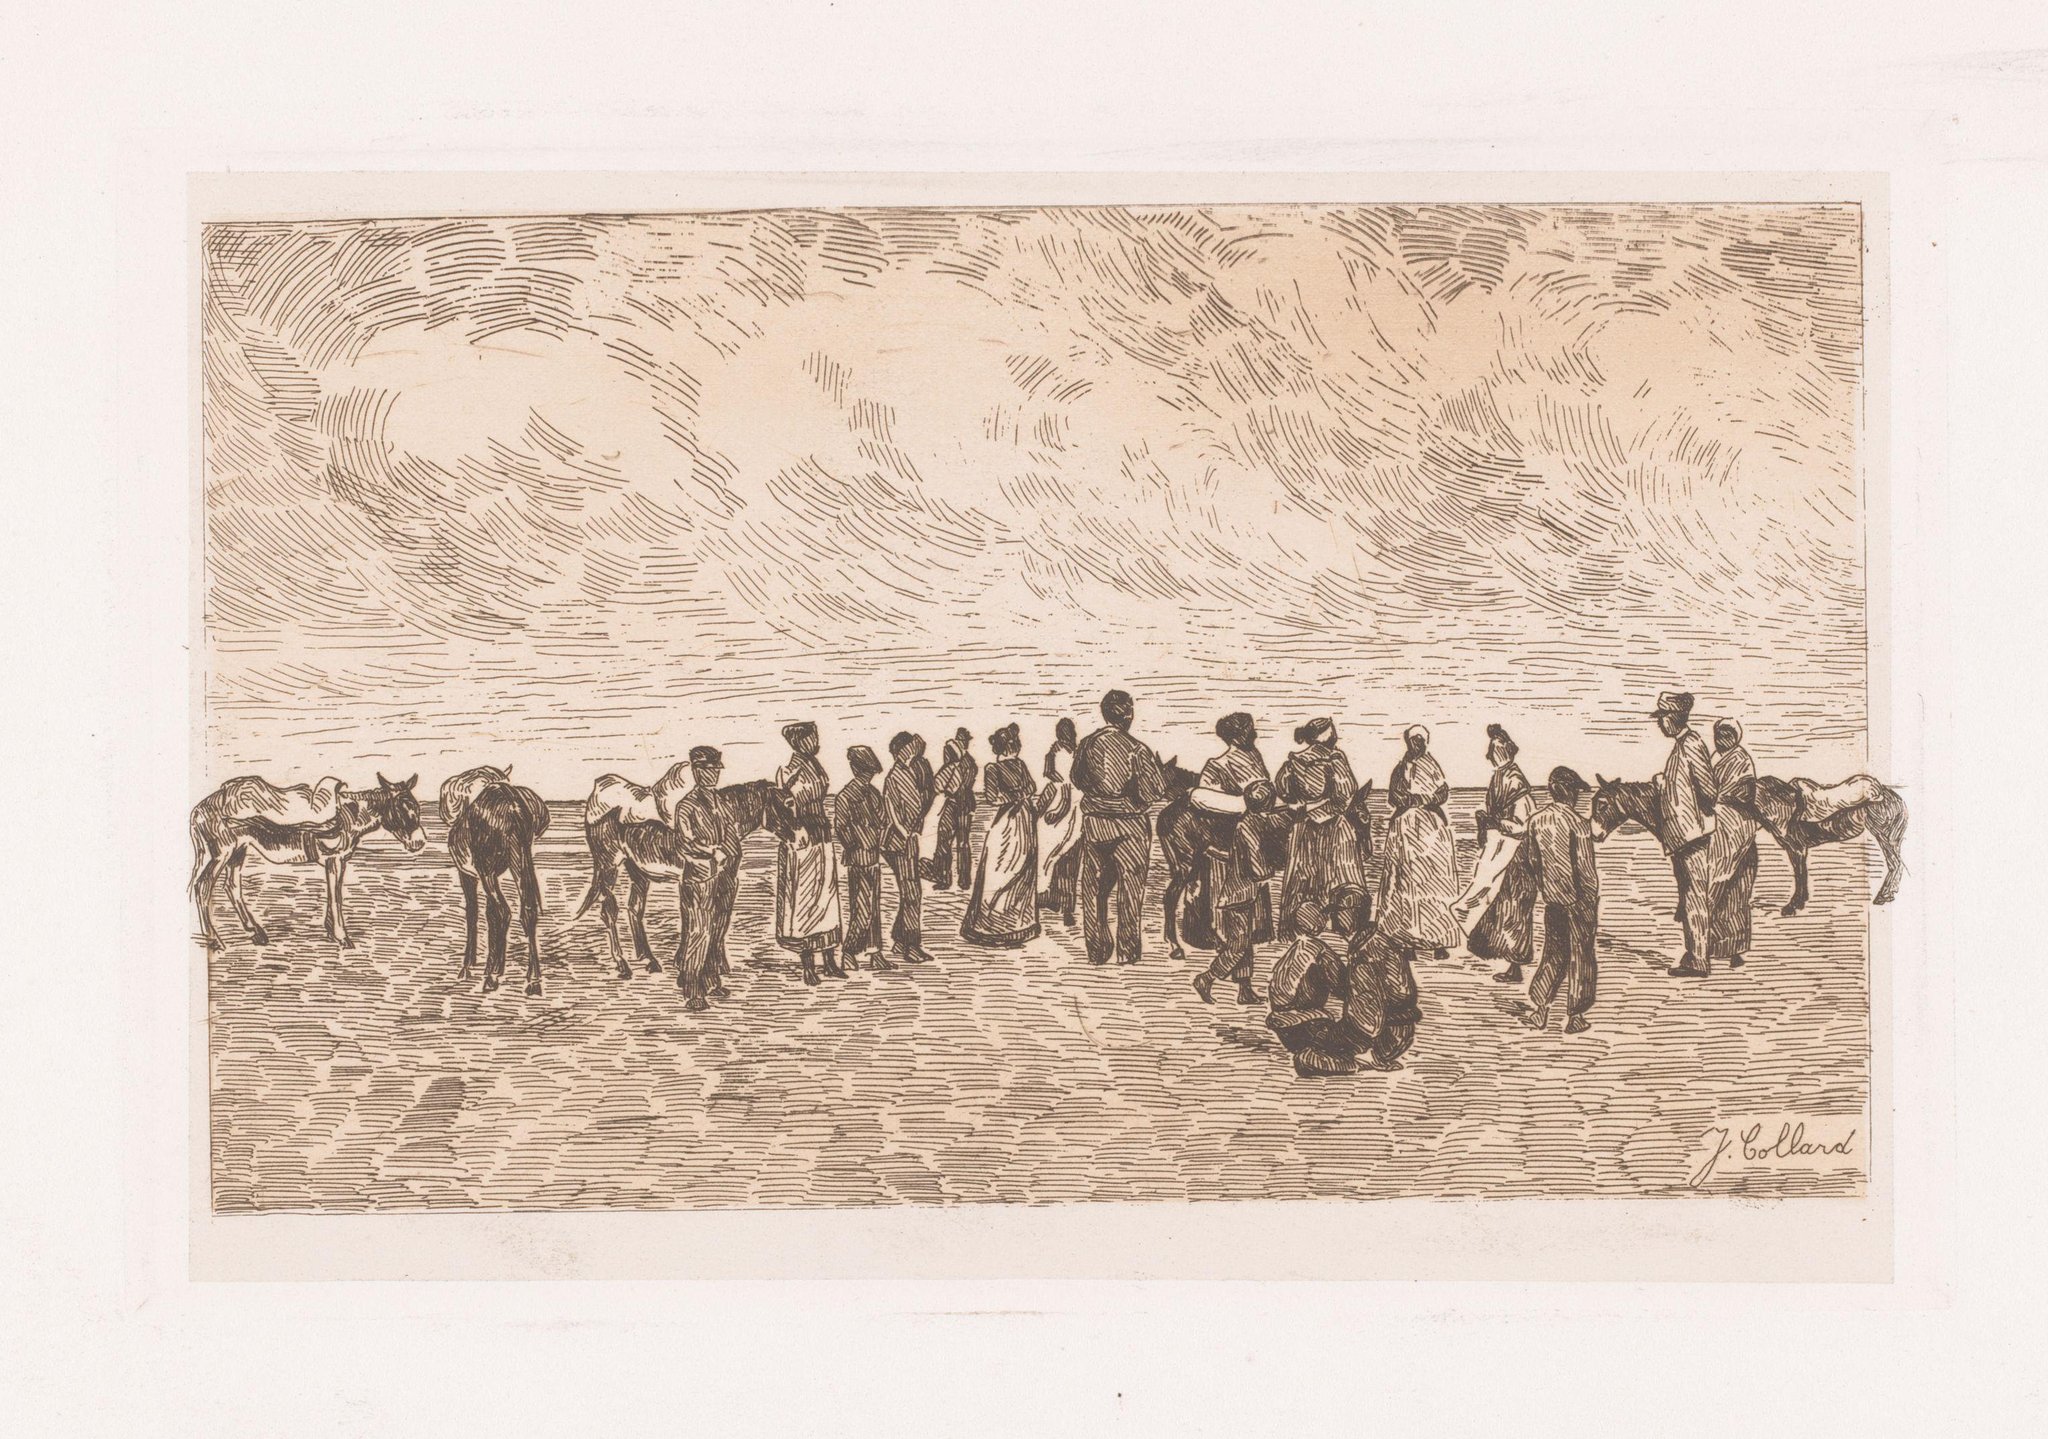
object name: print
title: Groep mensen met ezels aan het strand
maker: jean collard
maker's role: print maker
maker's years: 1881-1951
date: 1891-1909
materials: paper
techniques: etching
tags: beach (as place of recreation), ass, donkey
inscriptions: collector's mark: Lugt 2228